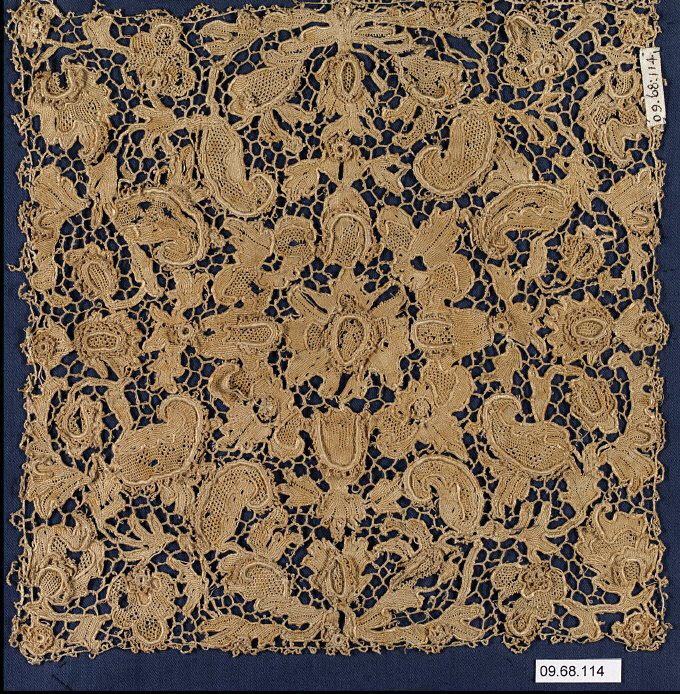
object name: square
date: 1601-1700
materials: silk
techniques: lace